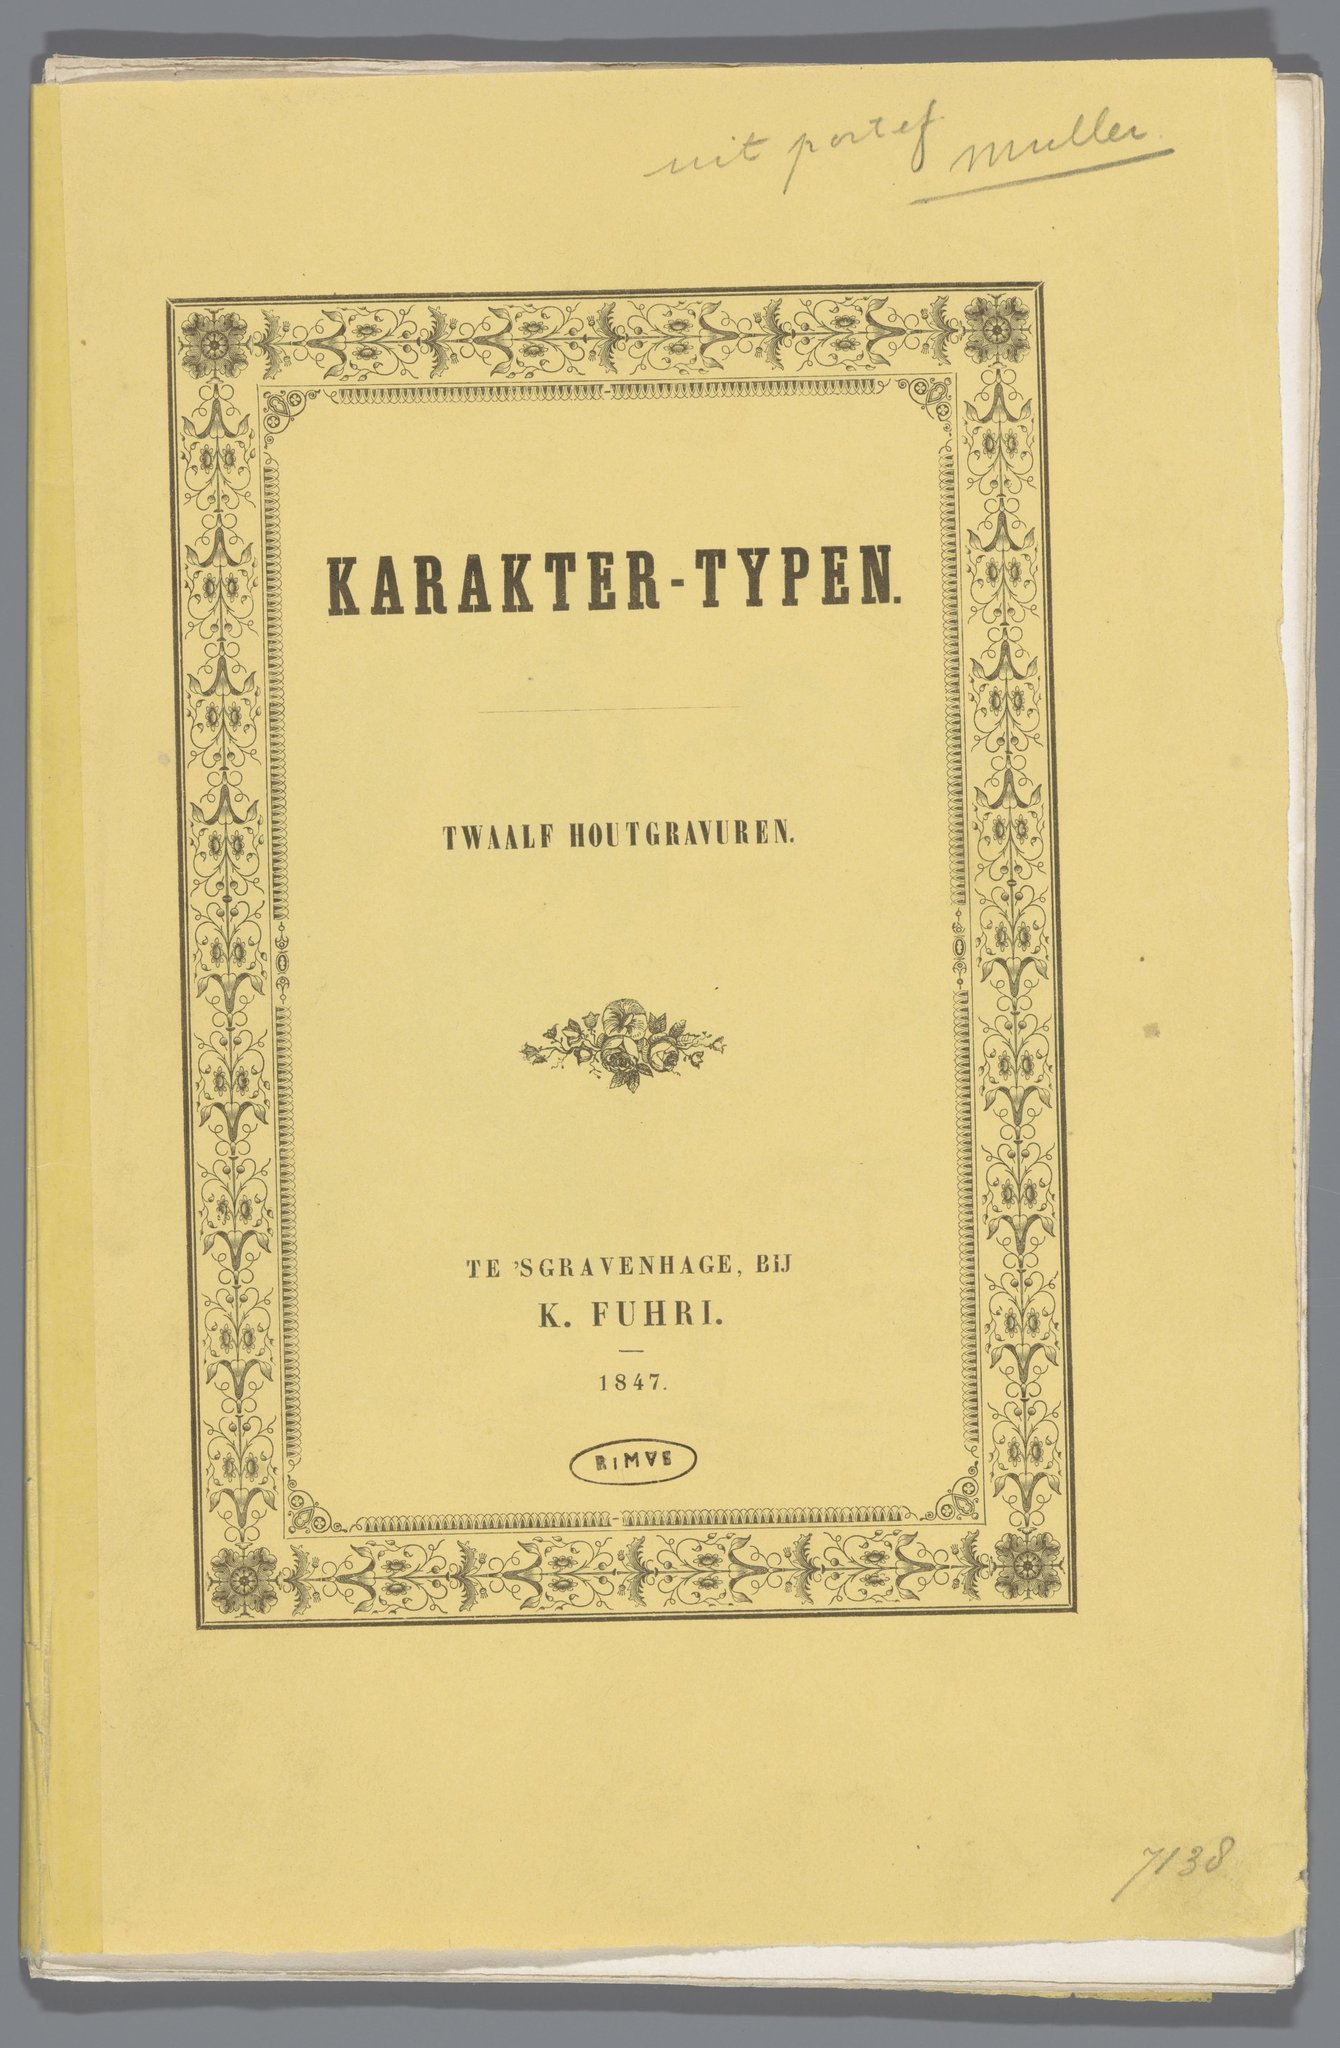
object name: folder container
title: Karakter-typen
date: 1847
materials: paper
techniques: letterpress printing, engraving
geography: the hague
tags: club, meeting place, boy (child between toddler and youth), ball, formal dance, moustache, girl (child between toddler and youth), politician, e.g. party leader, shoes, sandals, railway, train, umbrella, casino, father and son(s) (family group), 'en route', traveller under way, trunk, suit-case, military salutes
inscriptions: collector's mark: Lugt 2228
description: Map met twaalf prenten gemaakt door de Gebroeders van Arum en gedrukt door Koenraad Fuhri te Den Haag in 1847.